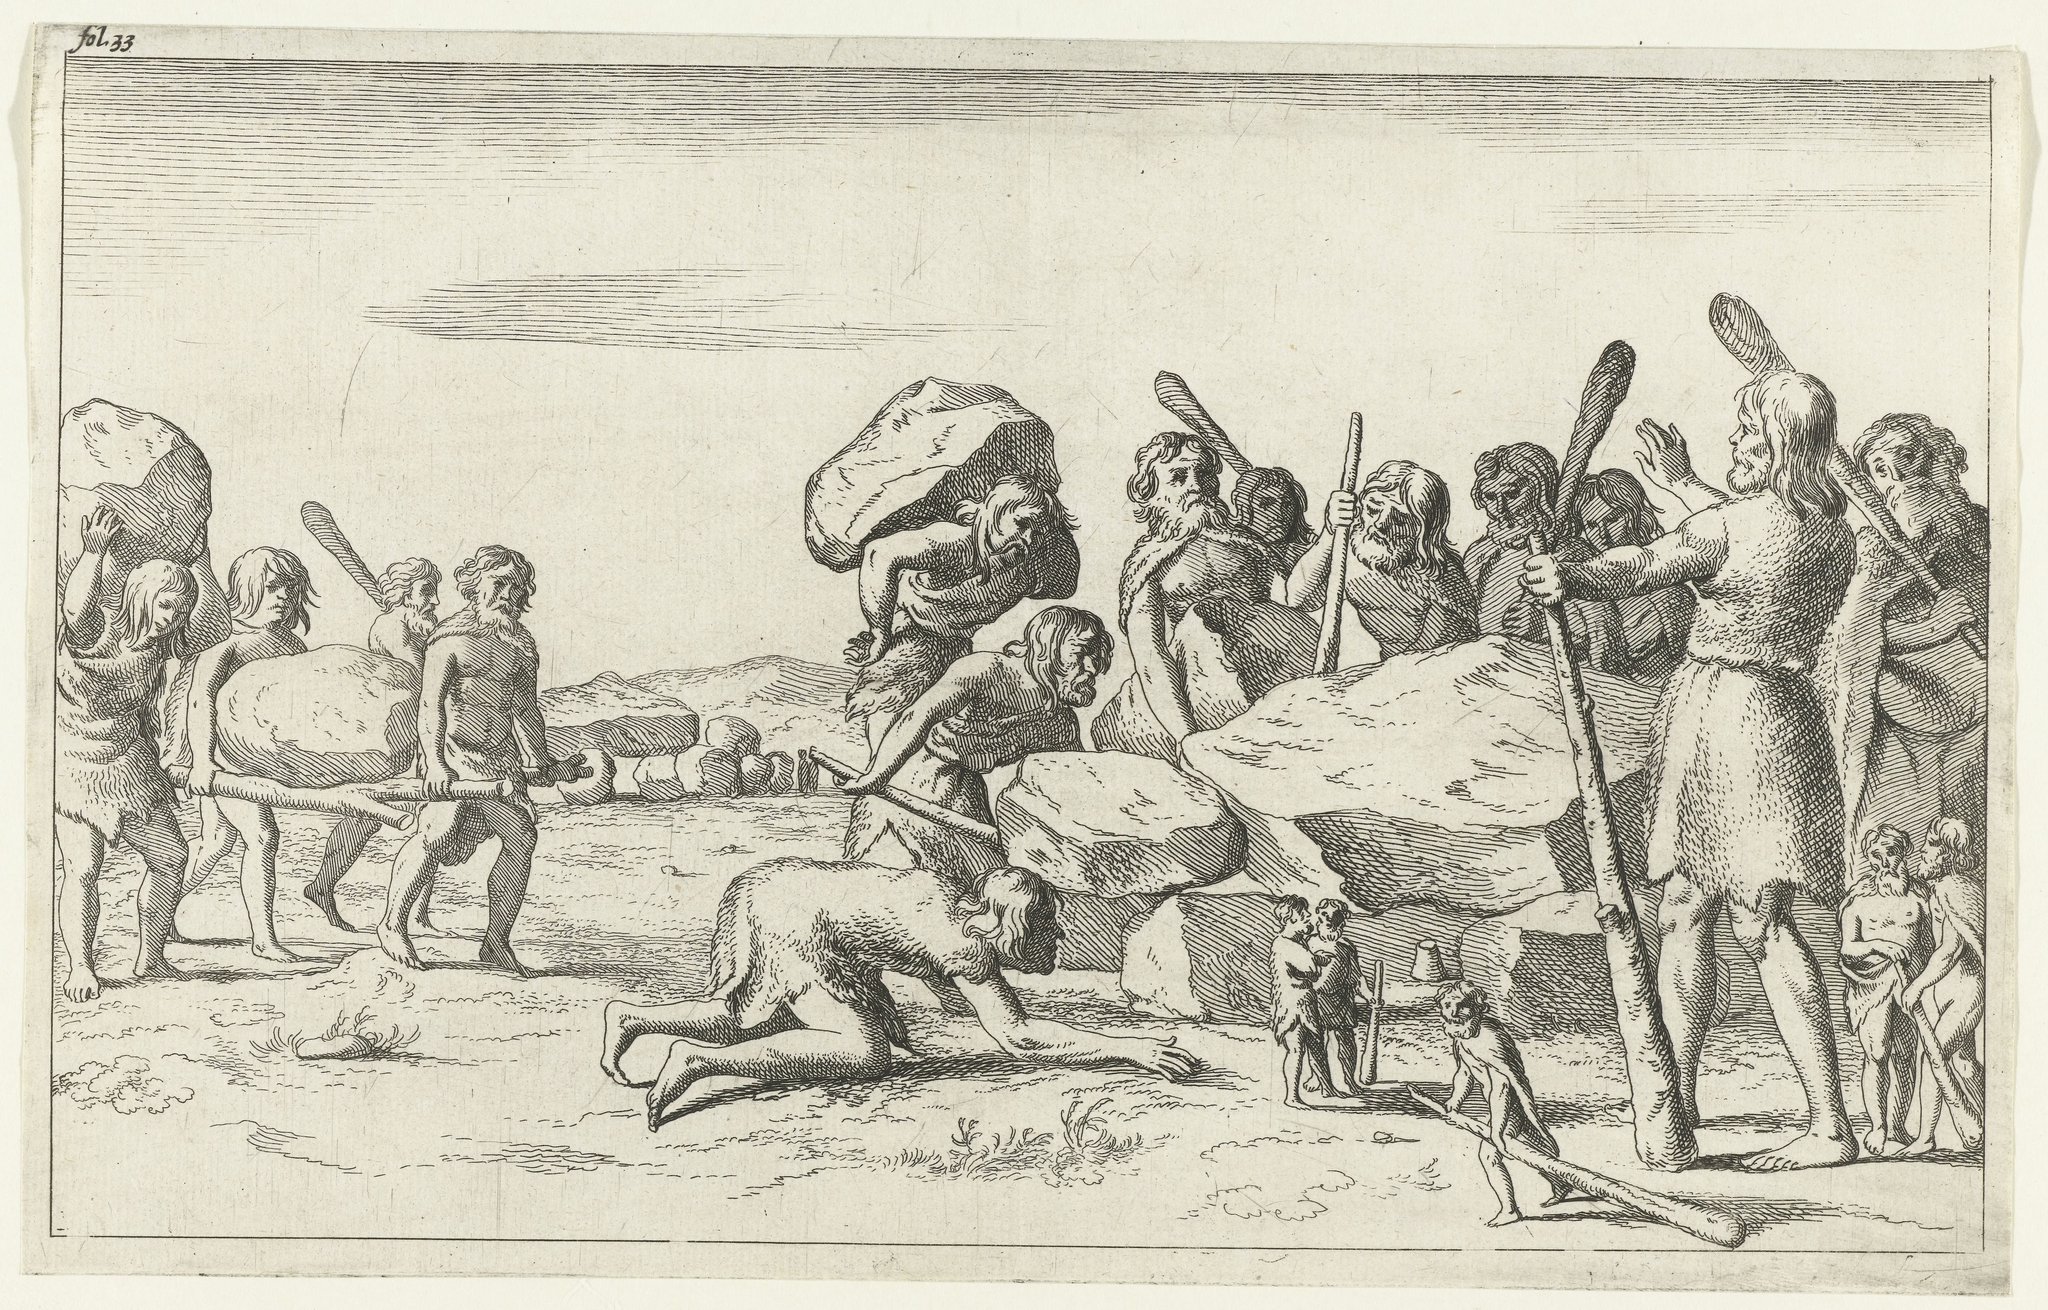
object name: history print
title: Reuzen bouwen hunebedden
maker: Anonymous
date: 1658-1660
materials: paper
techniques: etching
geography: netherlands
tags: prehistoric grave forms, netherlands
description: Illustratie voor: Johan Picardt, Korte beschryvinge van eenige vergetene en verborgene antiquiteten … in het antiquiteet-rijcke landschap Drenth, Tymon Houthaak, Amsterdam 1660, fol. 33.